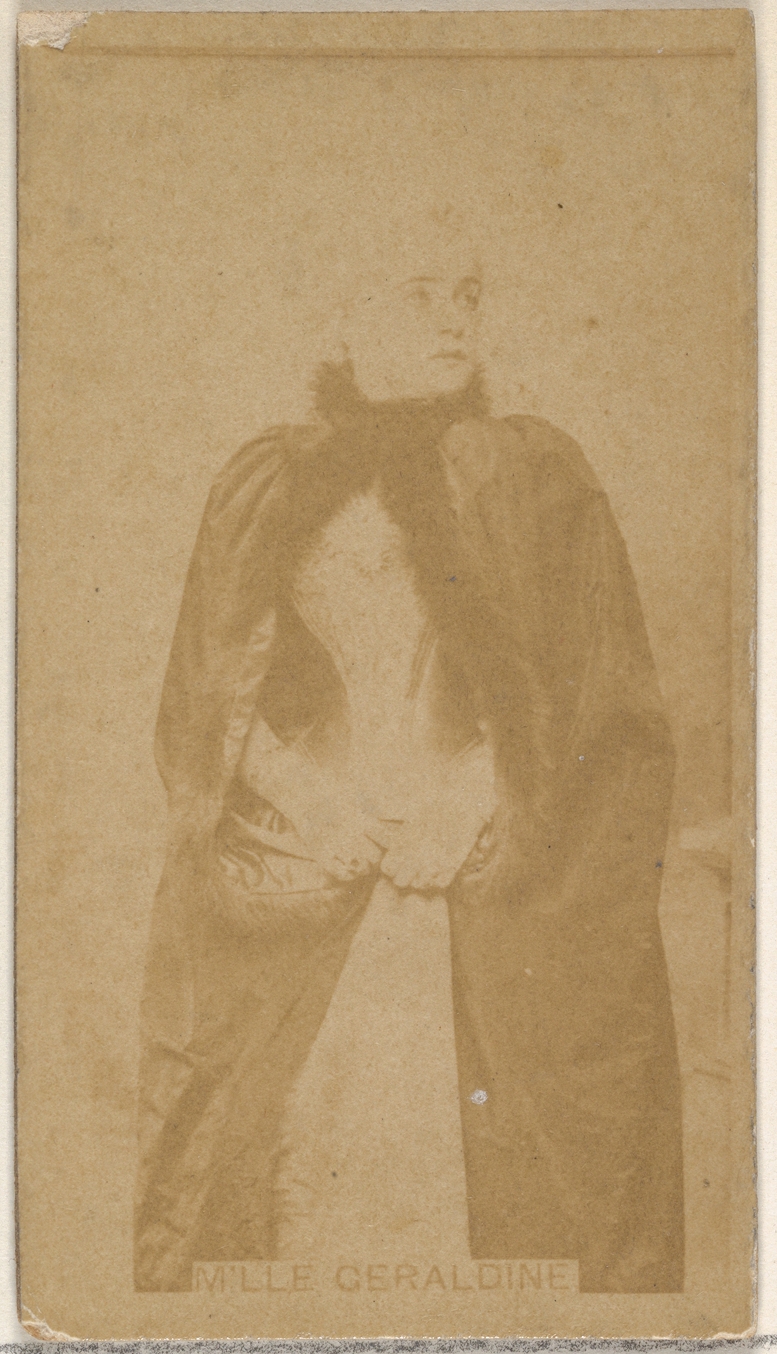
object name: photograph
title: M'lle Geraldine, from the Actors and Actresses series (N45, Type 8) for Virginia Brights Cigarettes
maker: allen & ginter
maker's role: publisher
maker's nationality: american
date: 1888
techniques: albumen silver print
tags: portraits,women,actresses